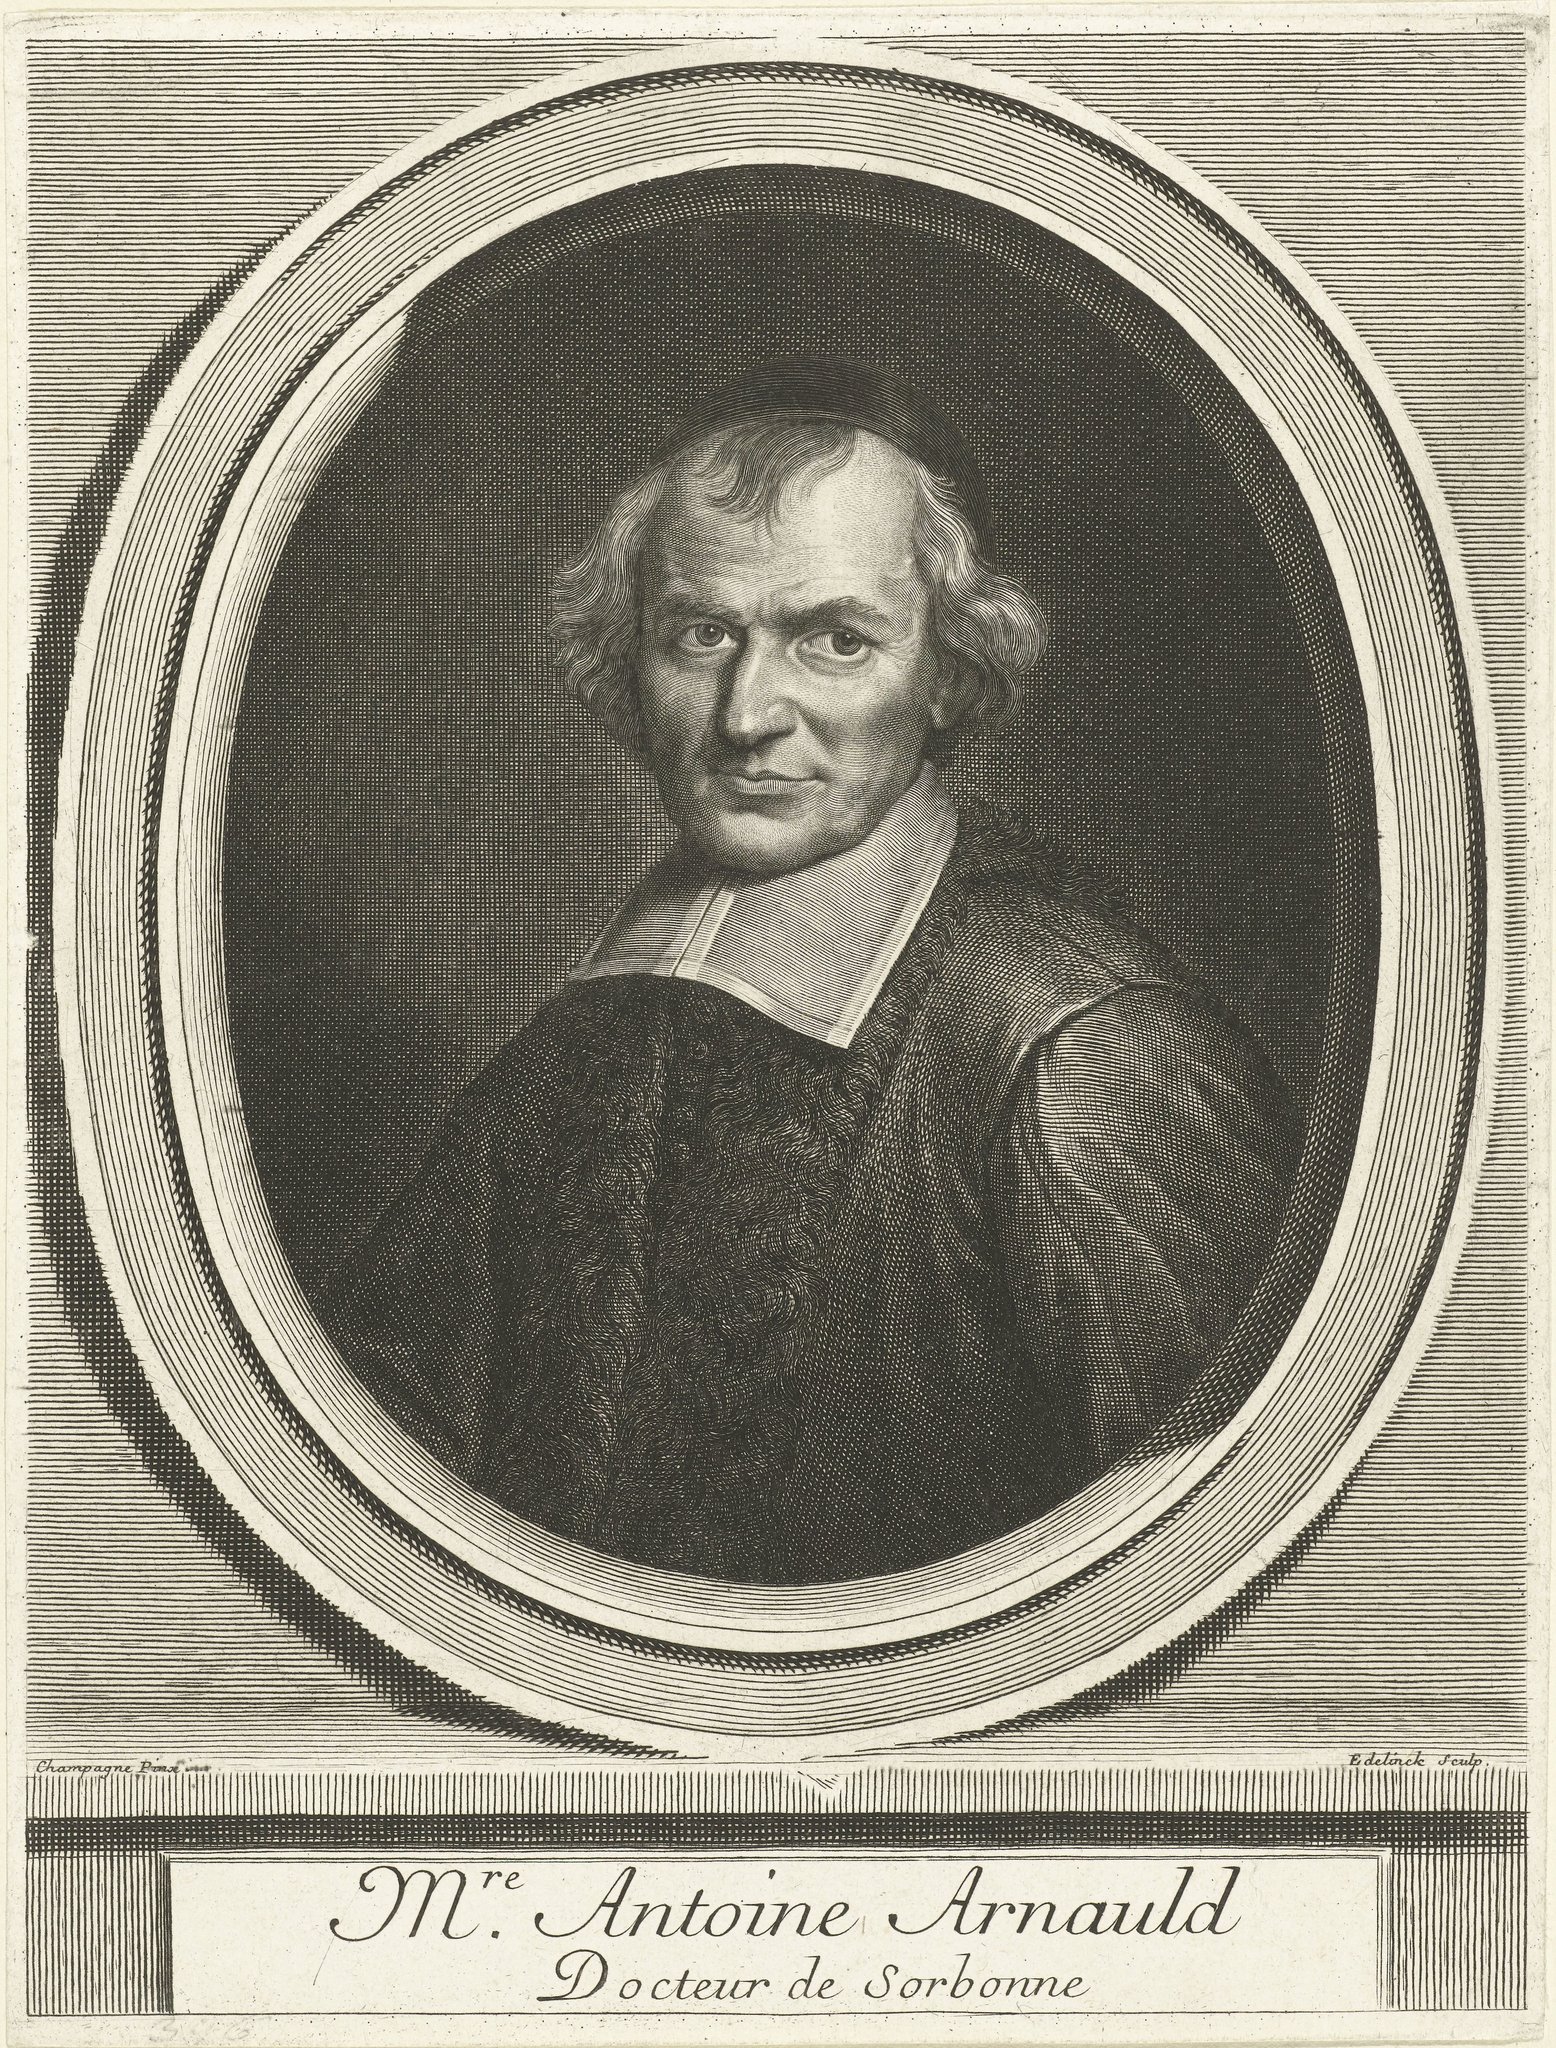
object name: print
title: Portret van Antoine Arnauld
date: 1652-1707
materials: paper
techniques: engraving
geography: france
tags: brussels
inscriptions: collector's mark: Lugt 240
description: Busteportret van de theoloog en filosoof Antoine Arnauld (1612-1694), afgebeeld in ovale omlijsting.